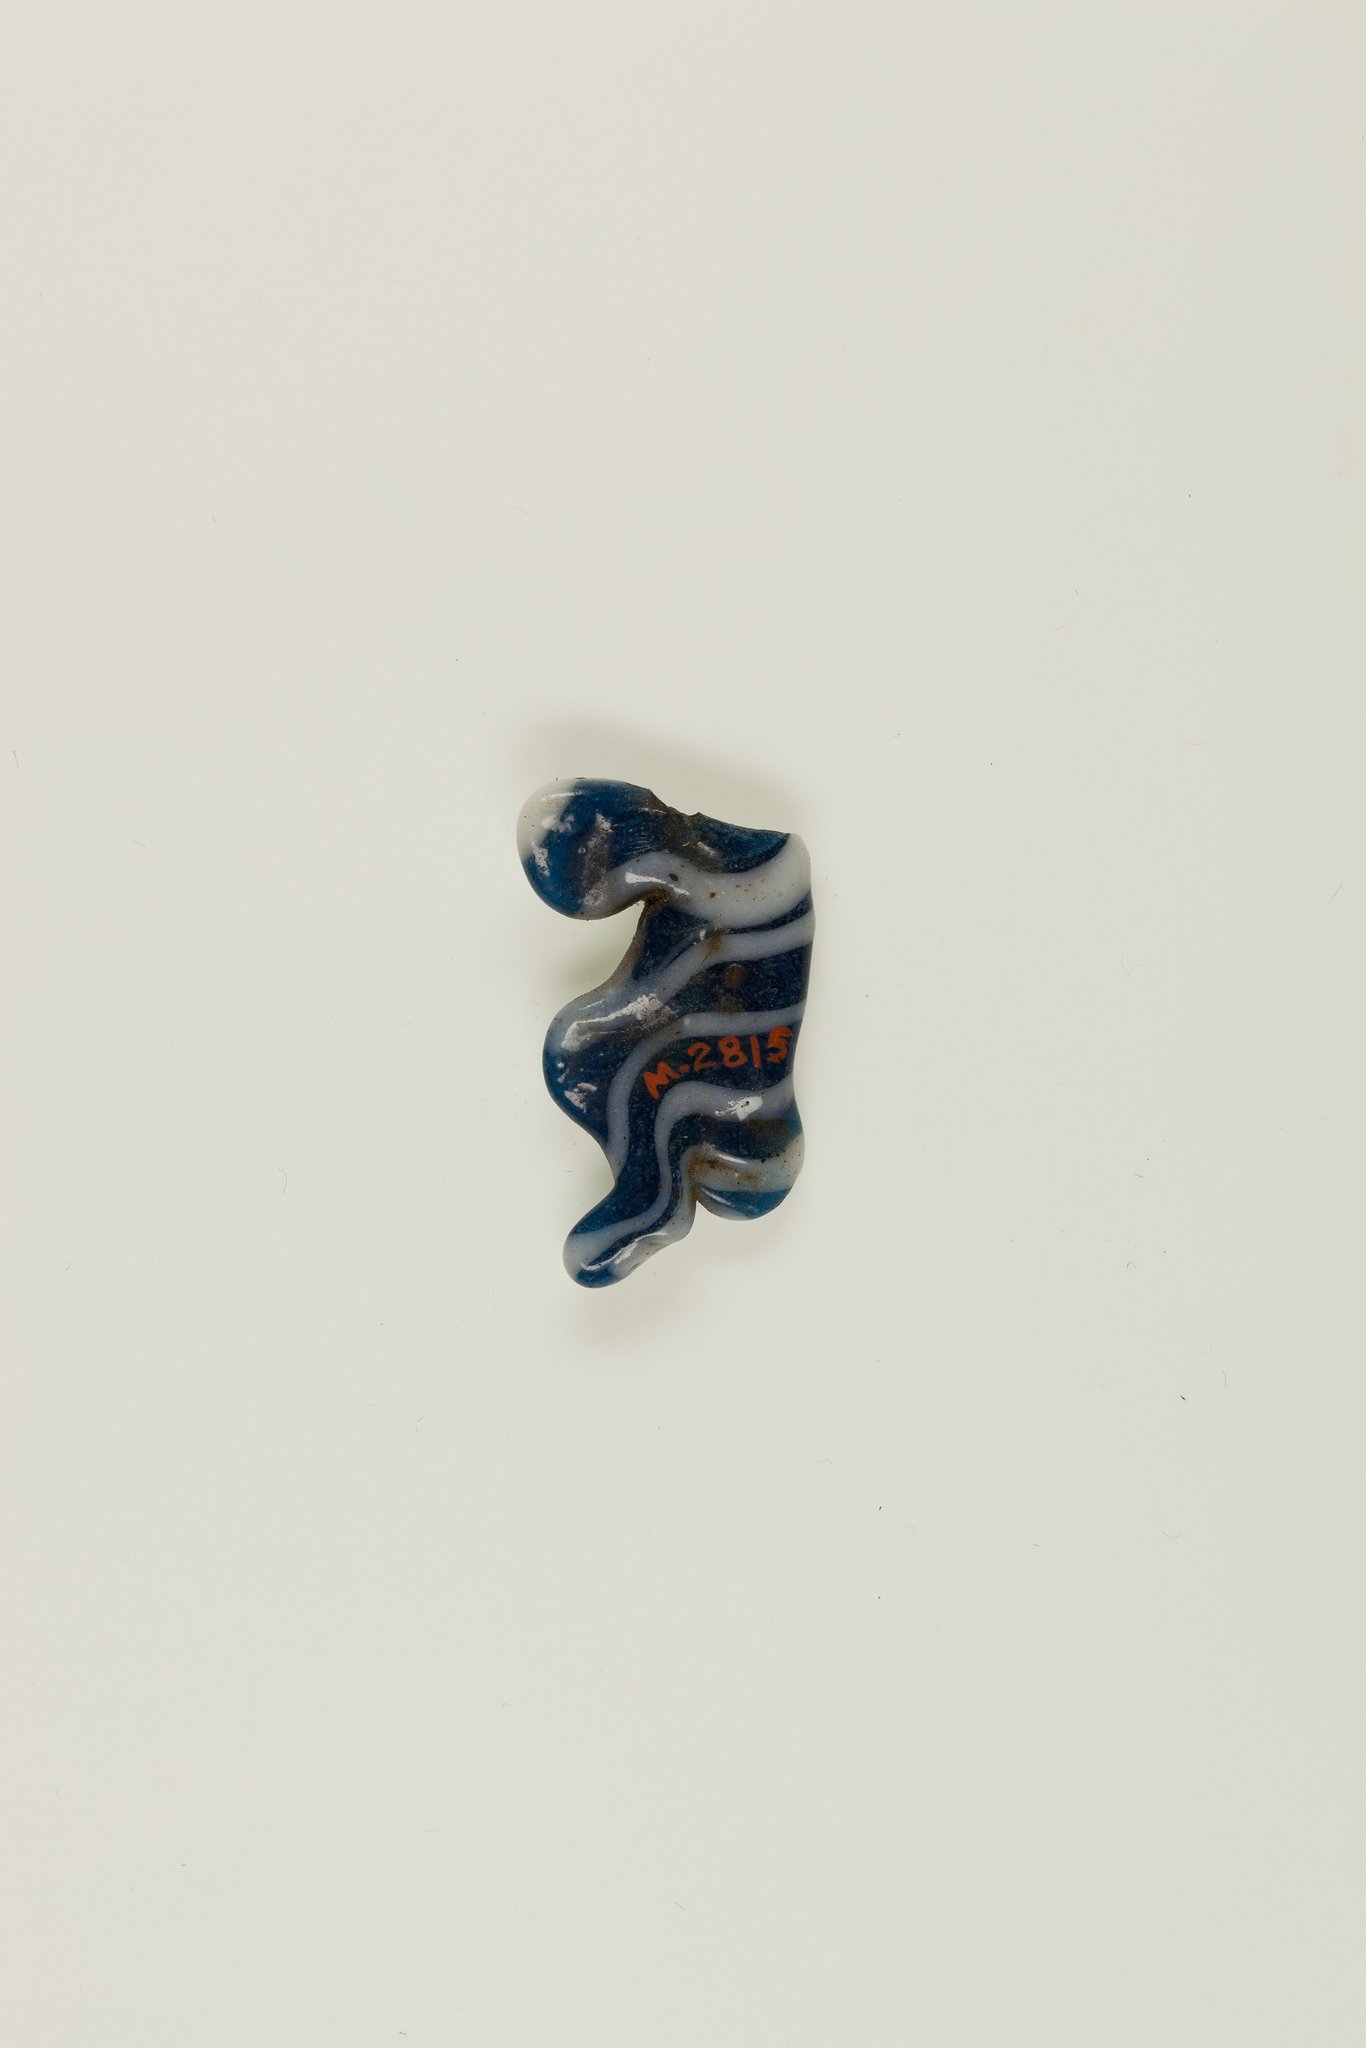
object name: amulet, taweret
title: Taweret amulet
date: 100 BCE-100 CE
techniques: mosaic glass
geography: egypt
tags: taweret